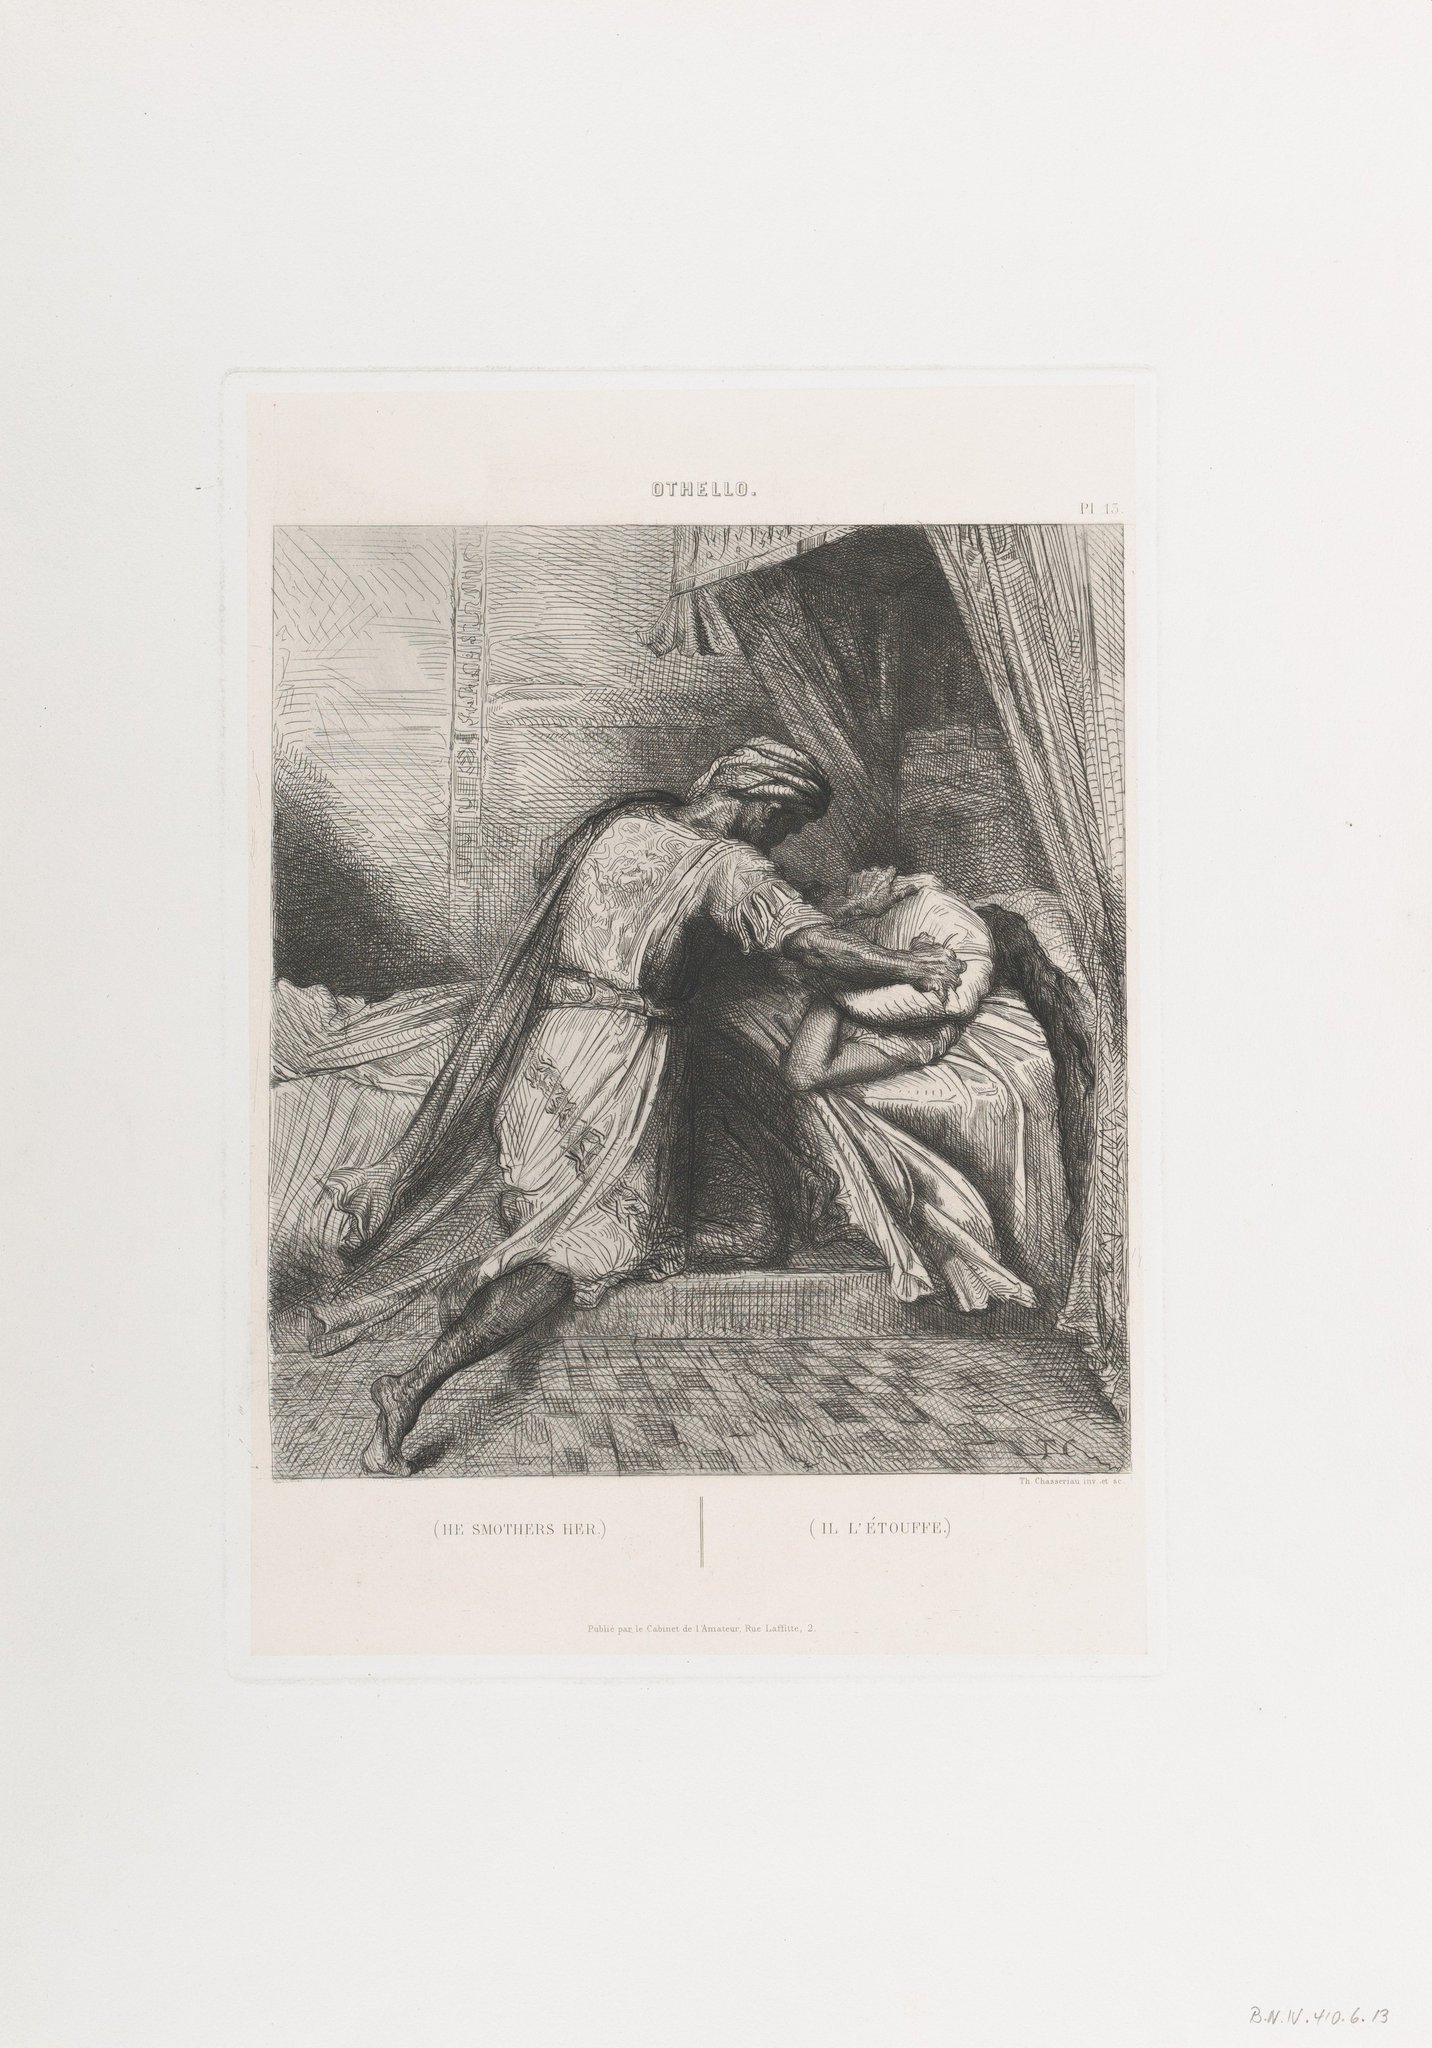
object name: print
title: "He smothers her": plate 13 from Othello (Act 5, Scene 2)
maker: théodore chassériau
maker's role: artist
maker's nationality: french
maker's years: 1819-1856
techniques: printmaking, engraving, etching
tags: bedrooms,shakespeare,men,women